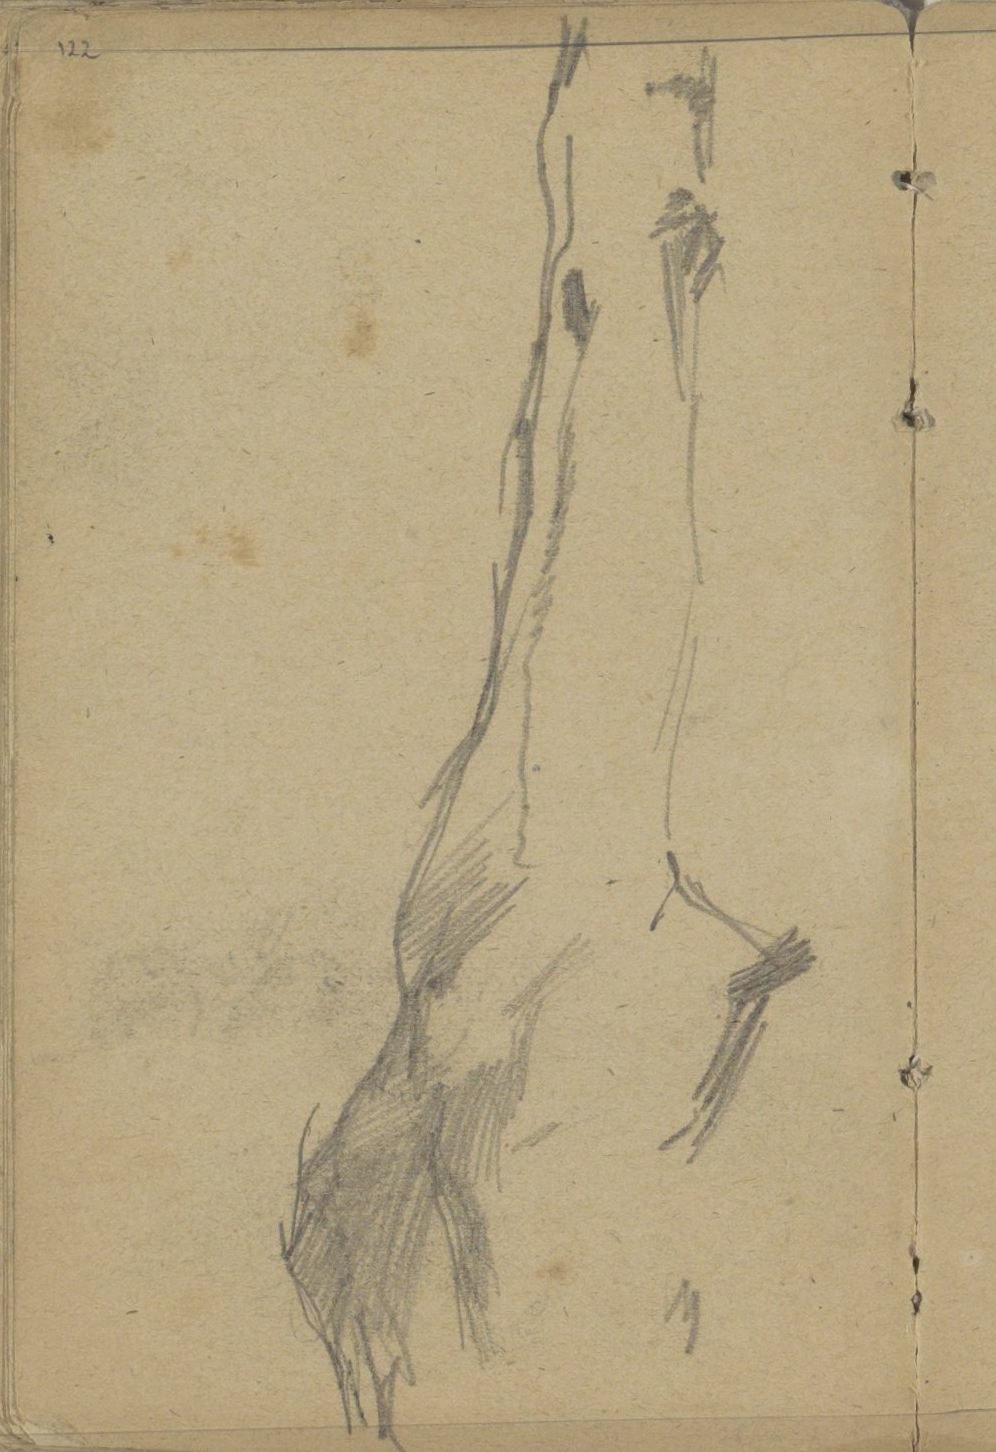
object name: sketchbook leaf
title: Paardenbeen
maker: george hendrik breitner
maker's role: draughtsman, painter, print maker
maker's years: 1857-1923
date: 1881-1883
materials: paper, pencil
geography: south holland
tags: horse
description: Paardenbeen. Pagina 122 uit een schetsboek met 70 bladen.